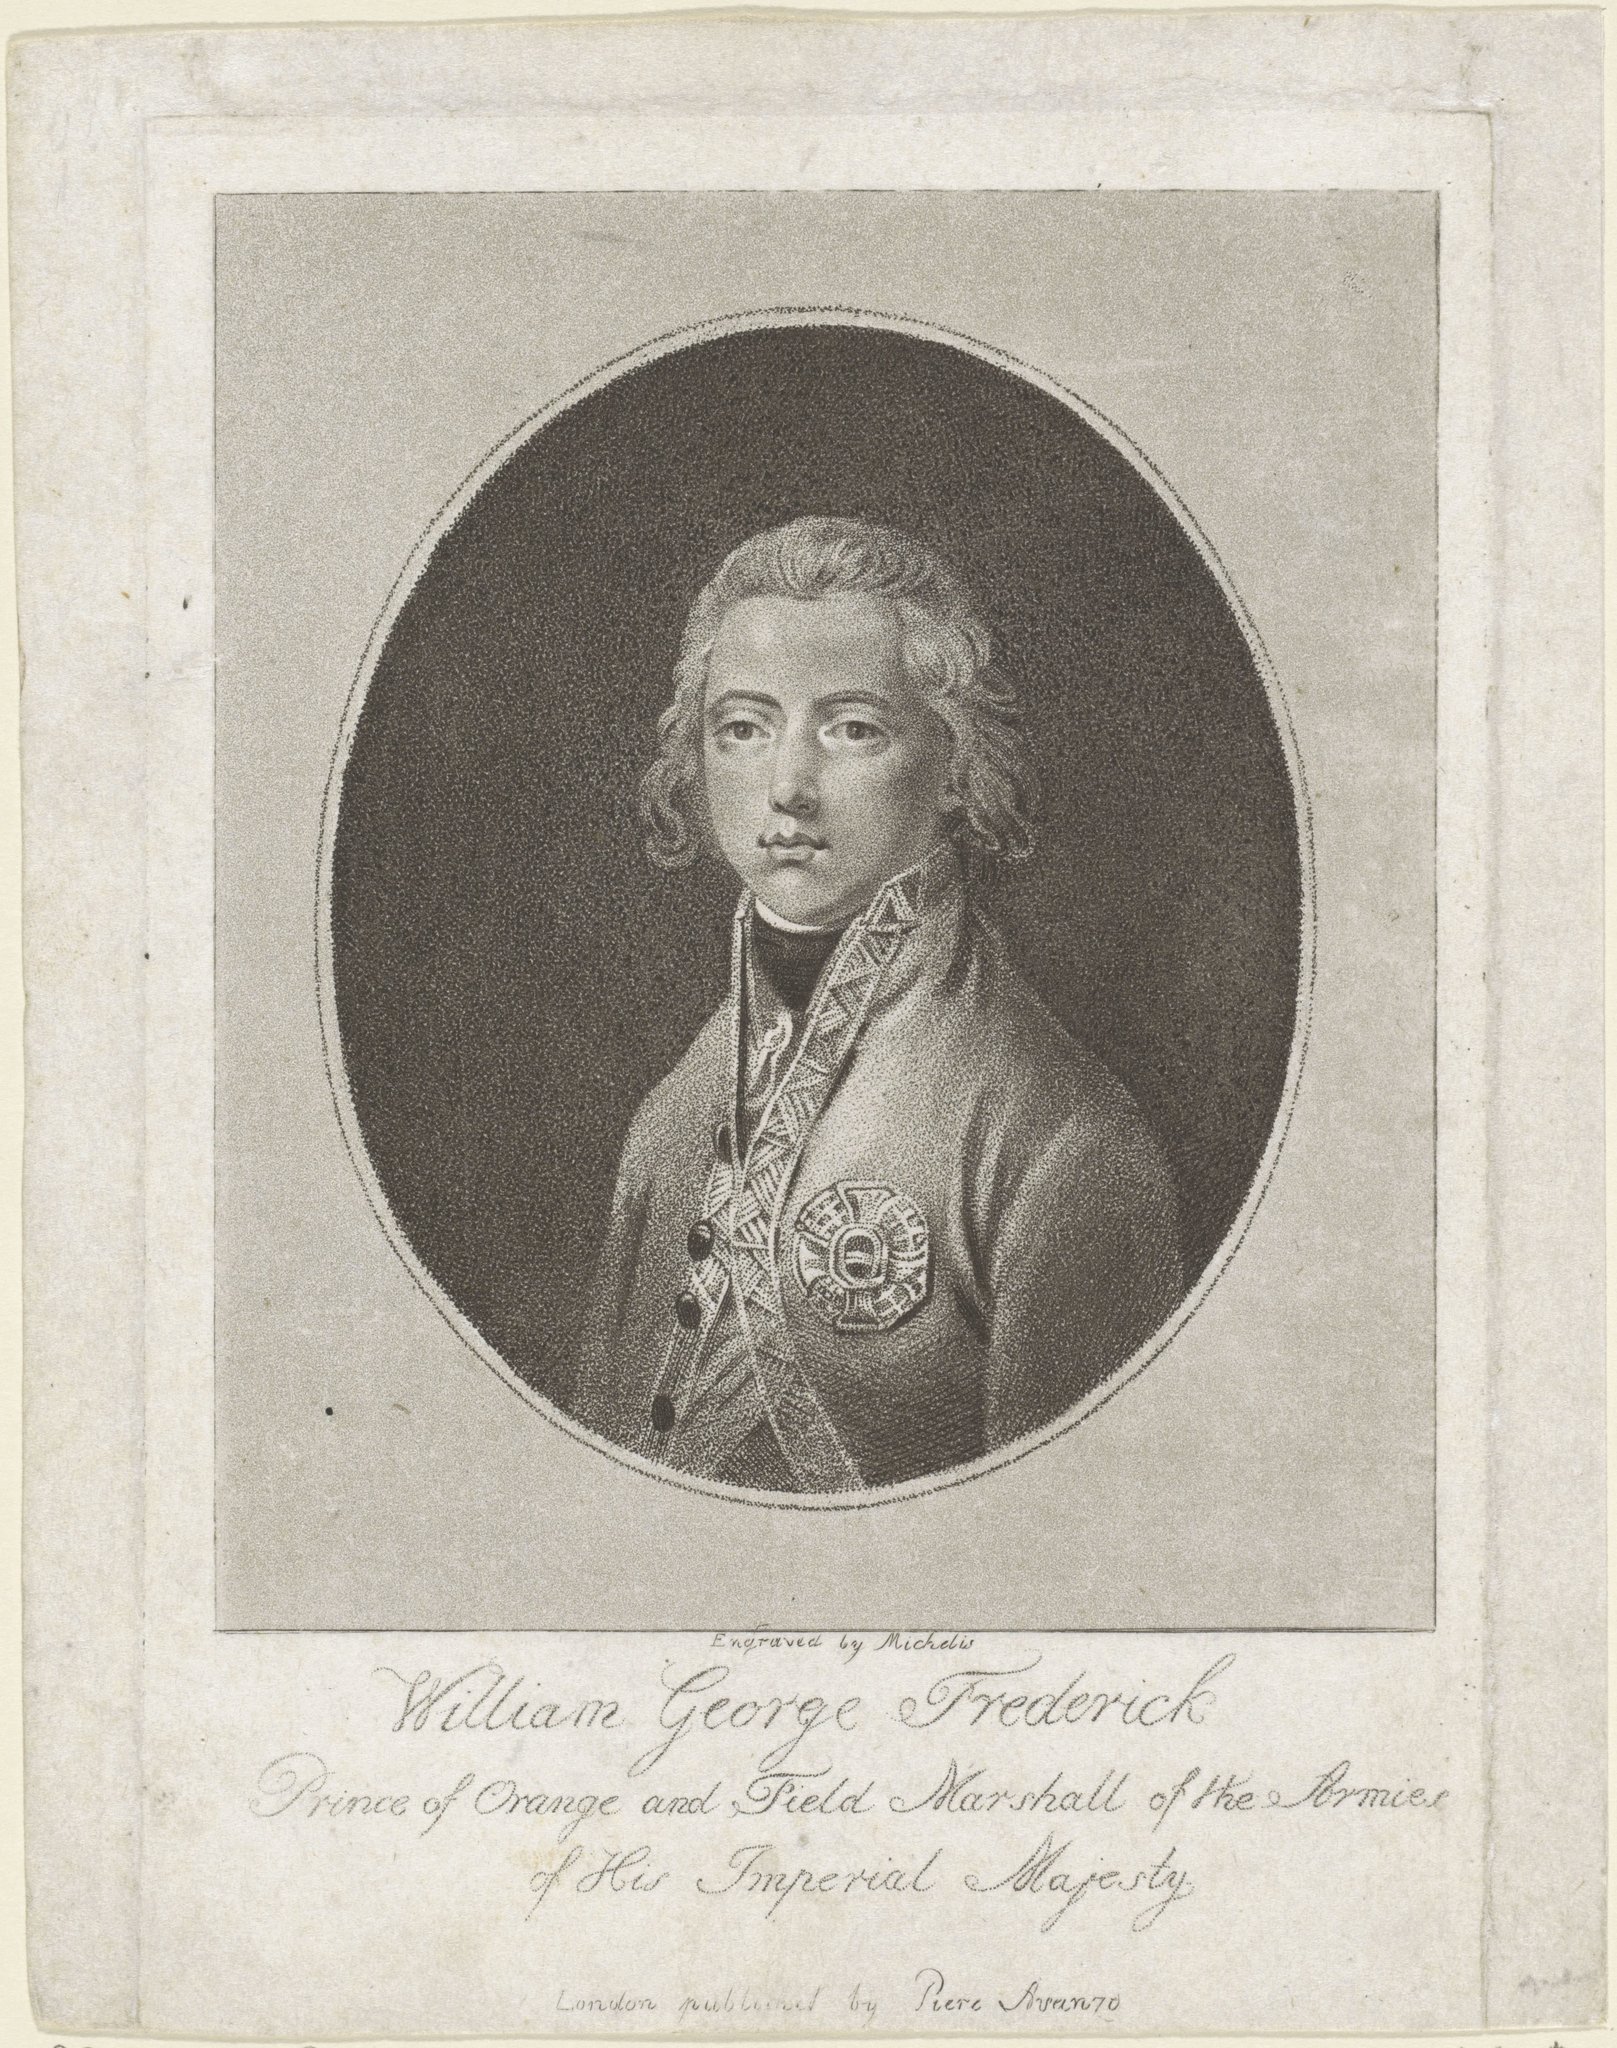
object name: print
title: Portret van Frederik, prins van Oranje-Nassau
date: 1790-1849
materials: paper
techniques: engraving, etching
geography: london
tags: the hague, willem george frederik (prins van oranje-nassau)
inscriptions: collector's mark: Lugt 2760, collector's mark: Lugt 2228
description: De hier vermelde titel verwijst naar de hoogst verkregen titel van de geportretteerde, niet per se naar de titel die de geportretteerde op deze voorstelling draagt.